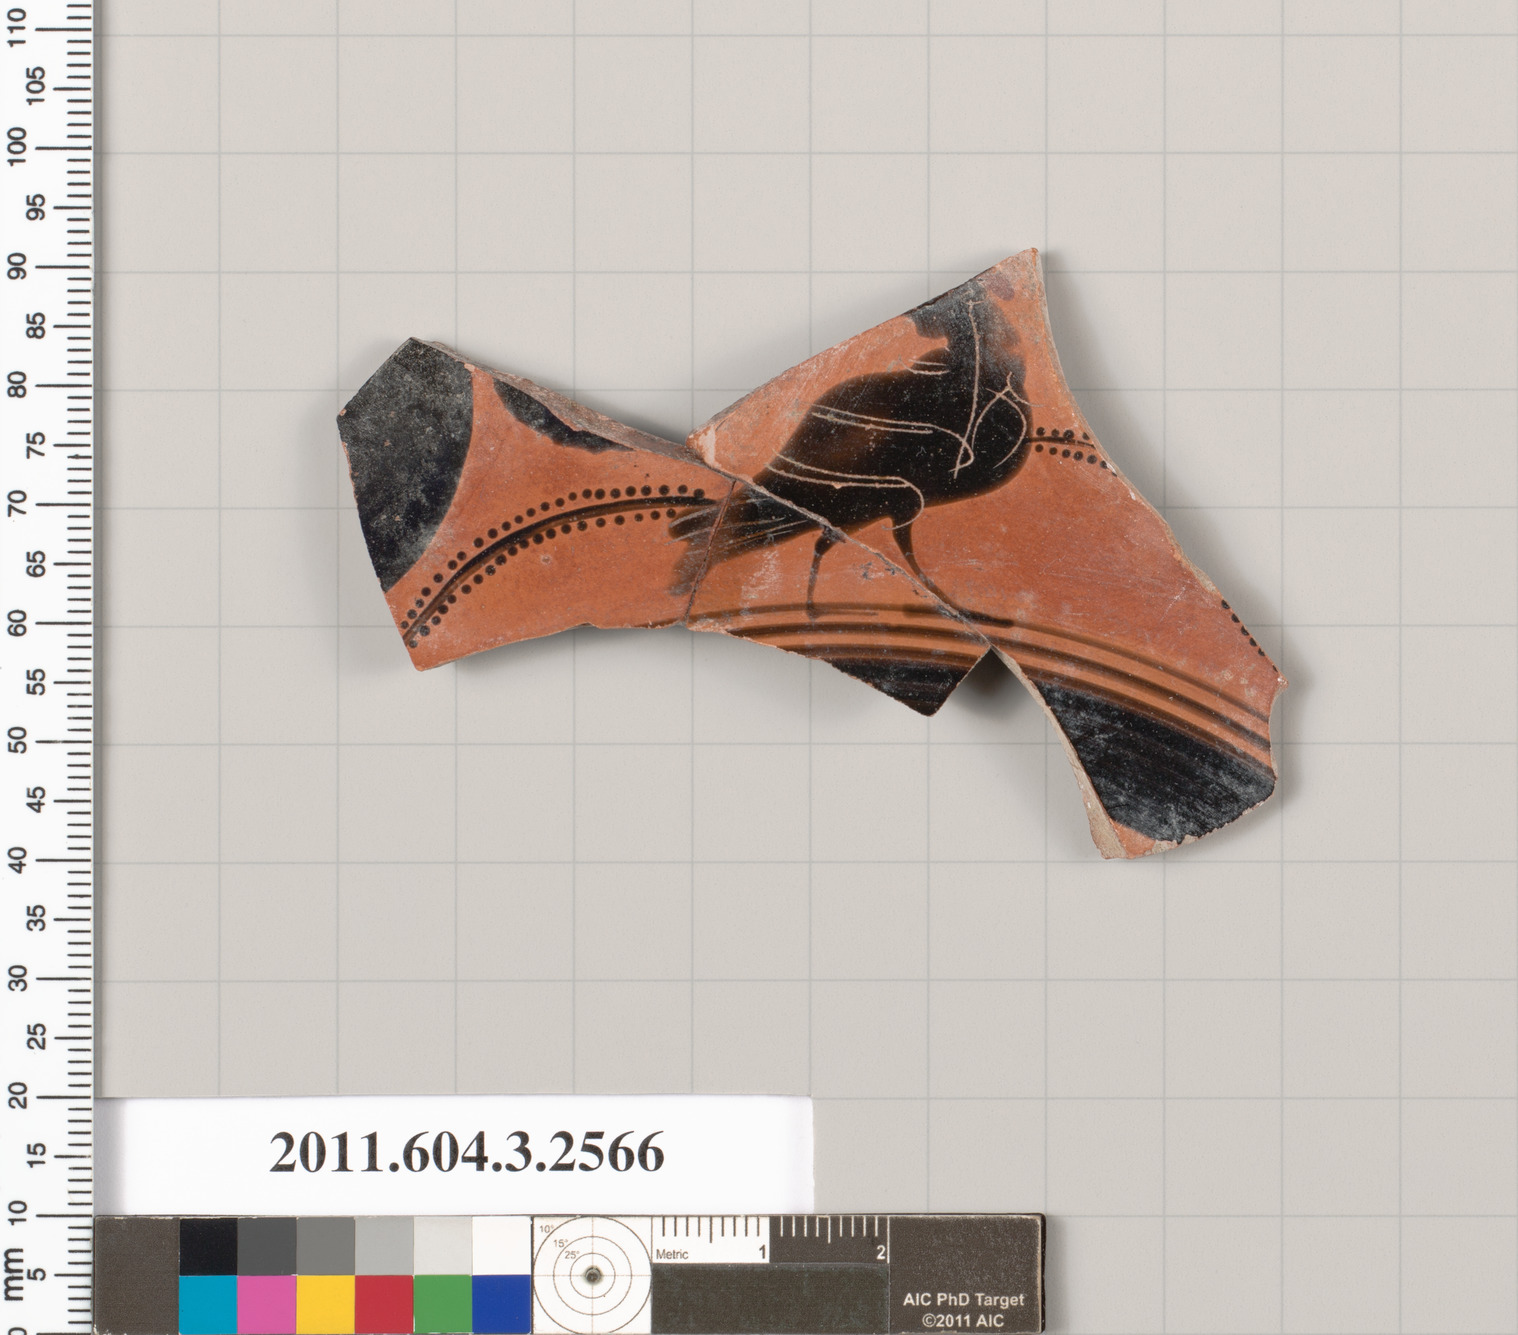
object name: kylix fragment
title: Terracotta fragment of a kylix: eye-cup (drinking cup)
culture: greek, attic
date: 530-520 BCE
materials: terracotta